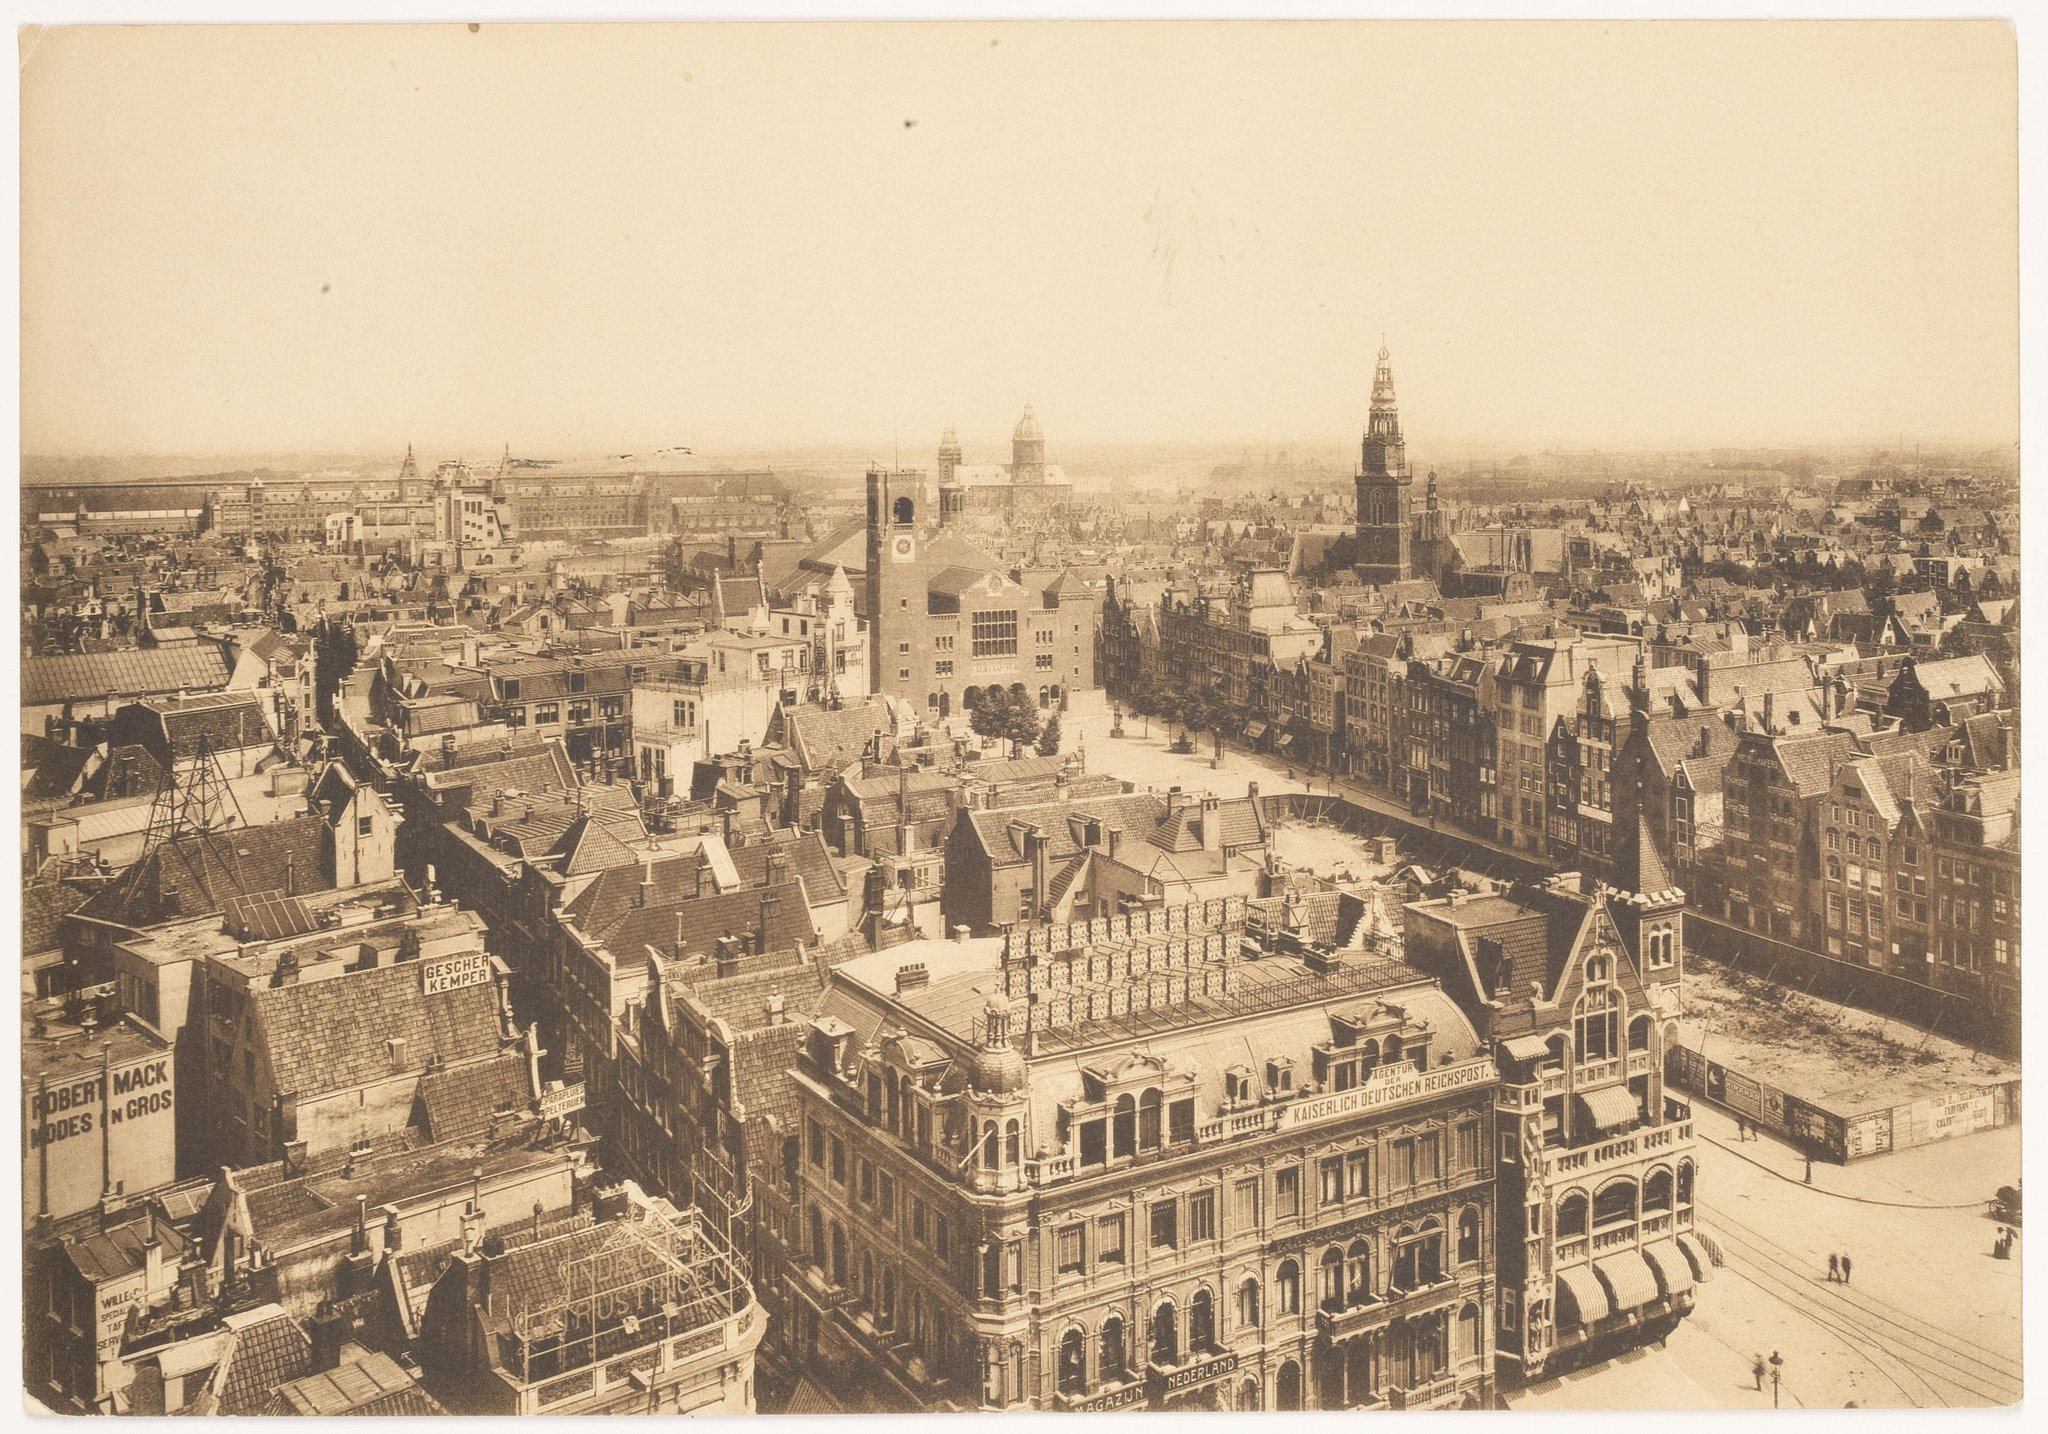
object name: photograph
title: 3. Panorama Amsterdam.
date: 1906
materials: paper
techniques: photograph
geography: amsterdam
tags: city-view in general; 'veduta'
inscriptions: annotation: ‘PAnorama Amsterdam. uitgave N.J. Boon Amsterdam’